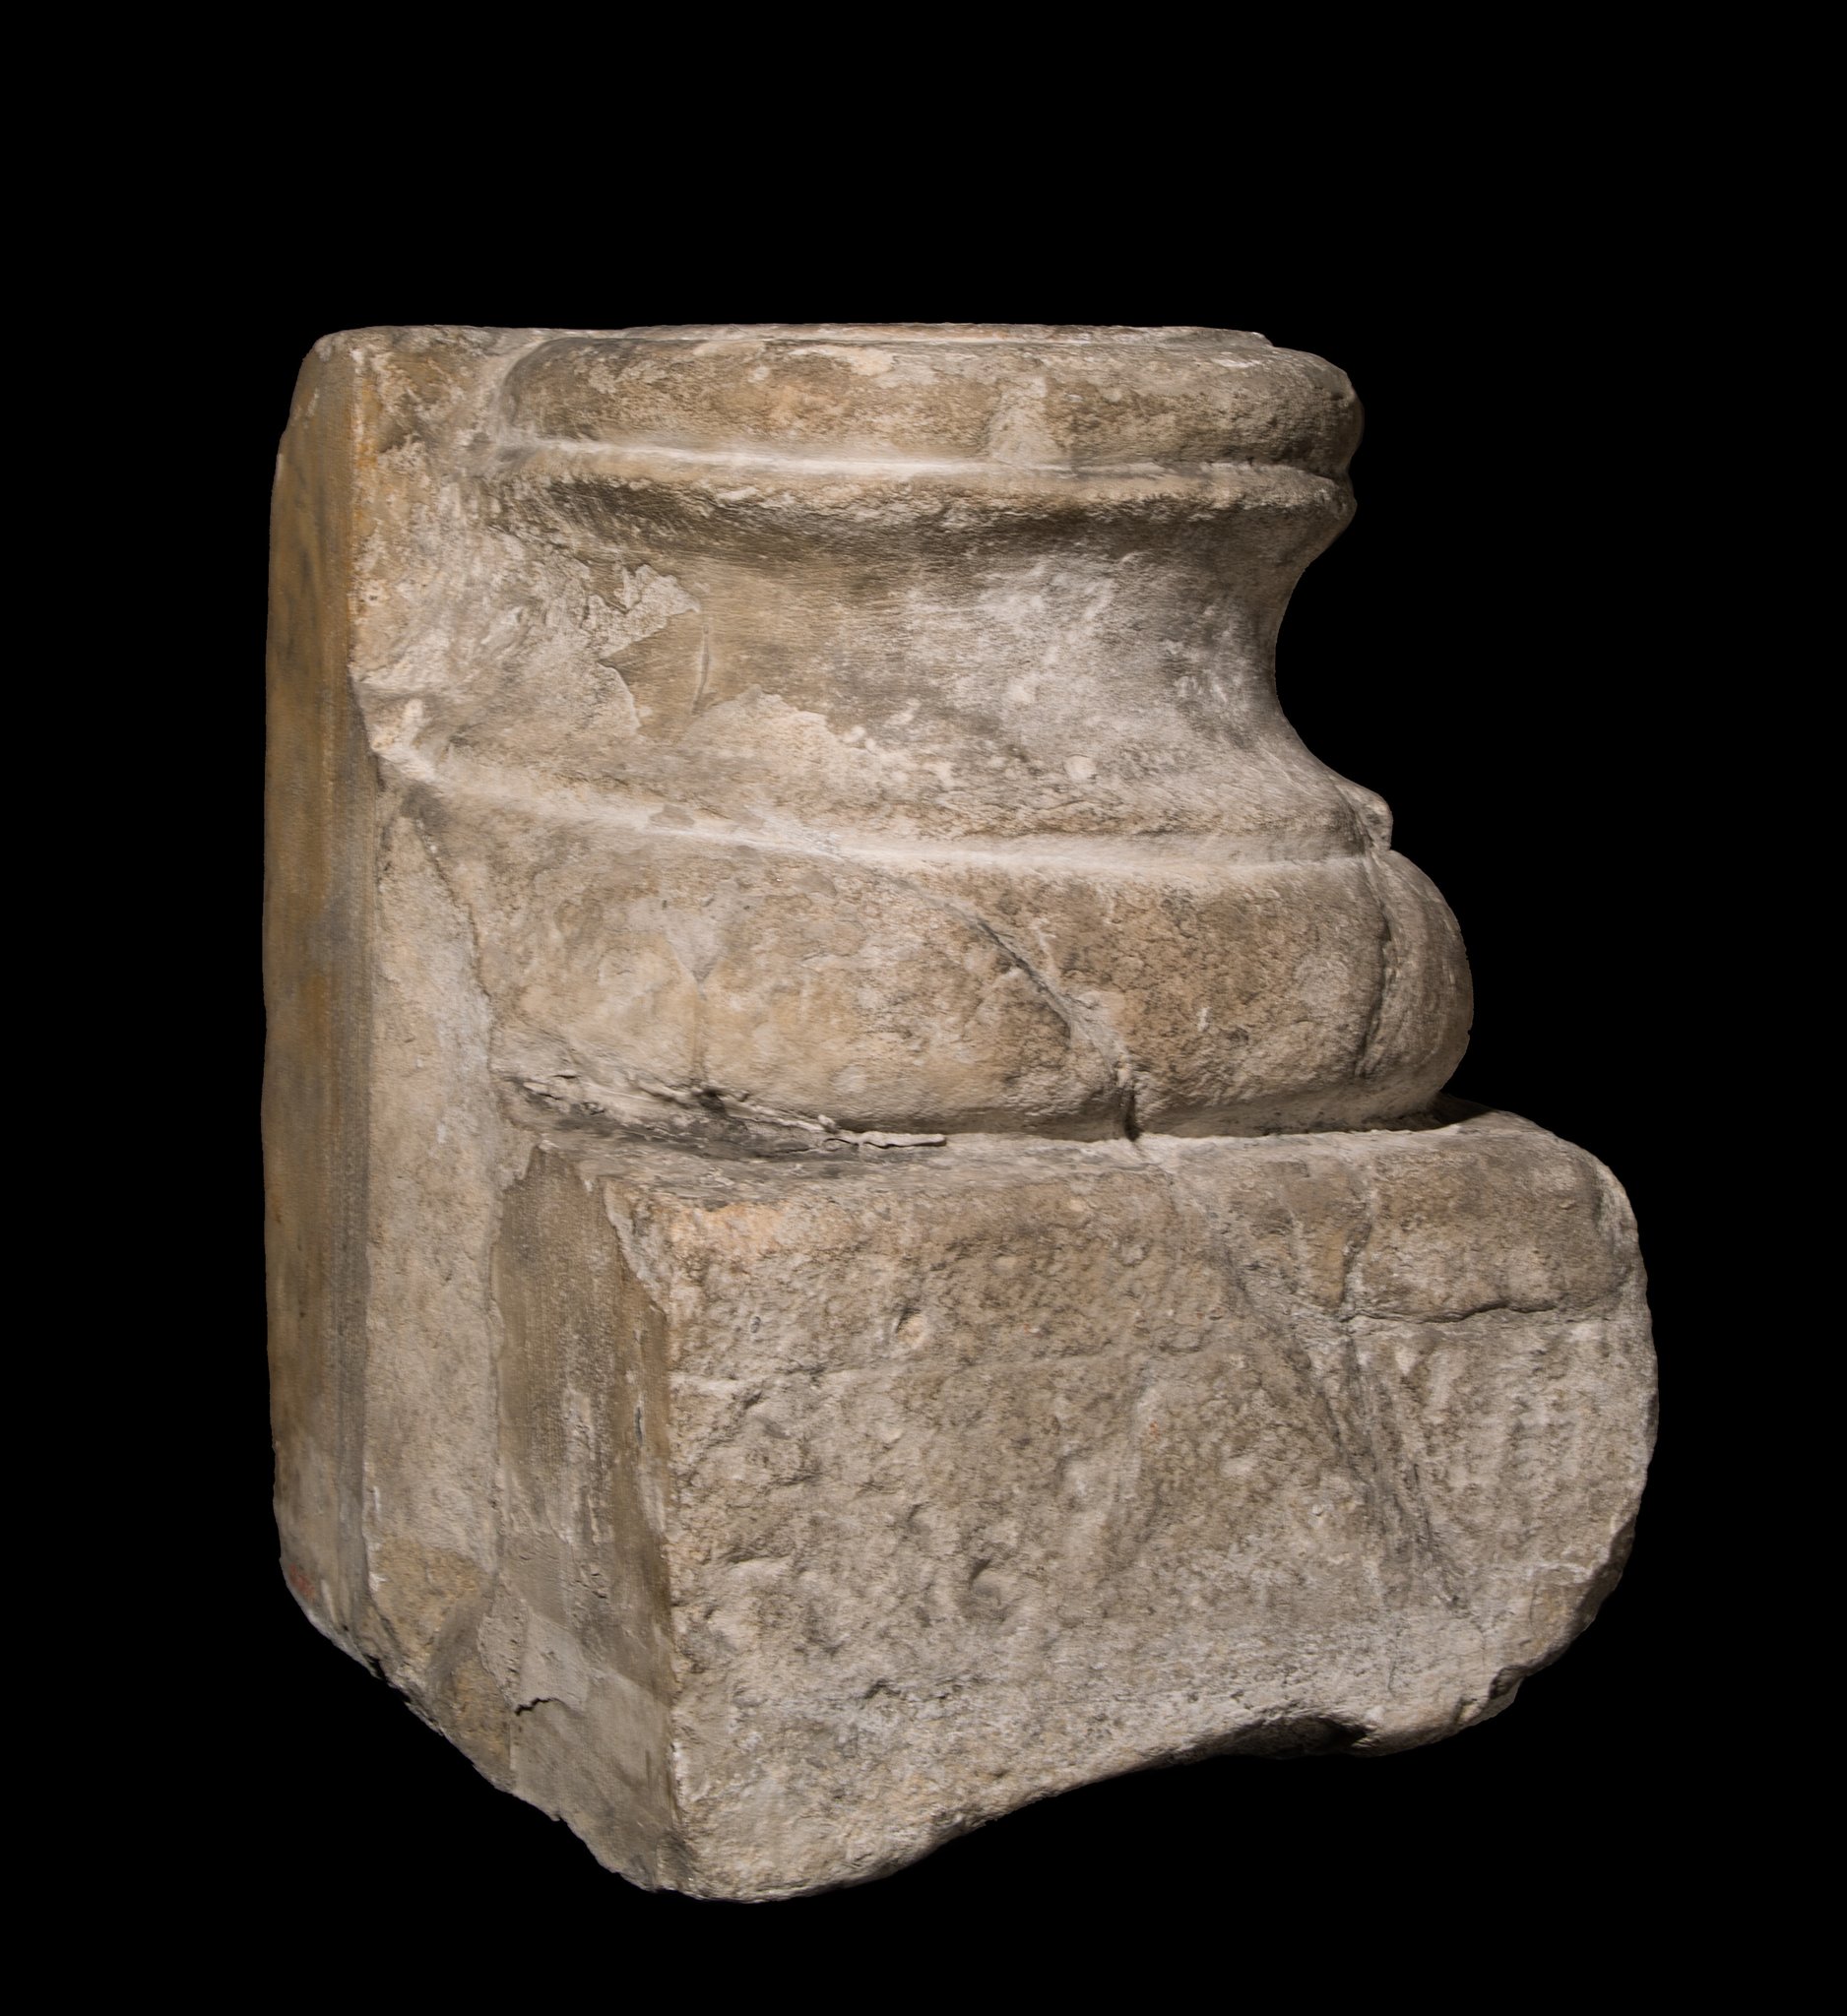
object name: column base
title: Engaged Column Base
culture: french or italian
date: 1001-1300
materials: stone